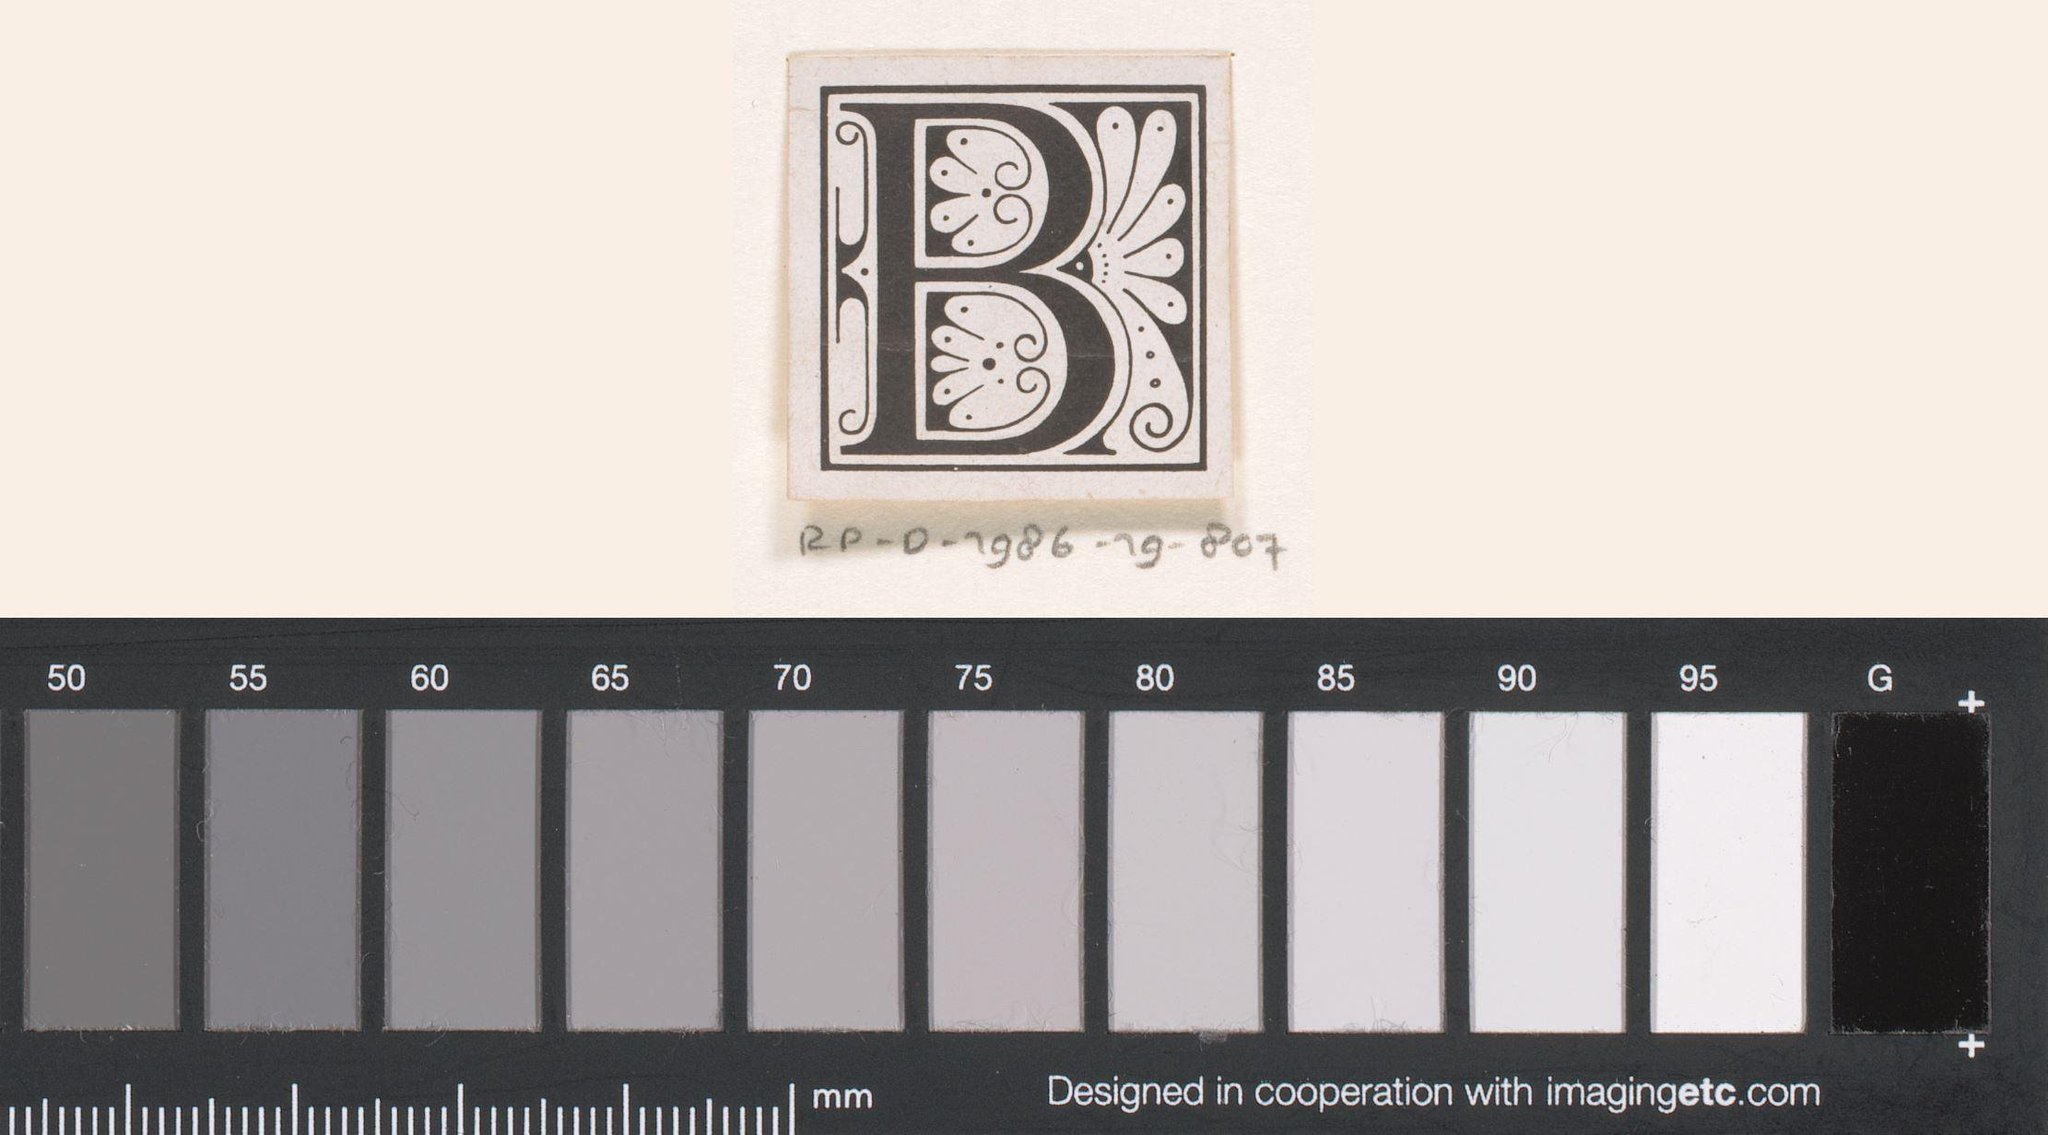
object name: photomechanical print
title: Initiaal B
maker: reinier willem petrus de vries (1874-1953)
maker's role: draughtsman, print maker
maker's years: 1874-1953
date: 1904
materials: paper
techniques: printing block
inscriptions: collector's mark: ‘R:MVS.’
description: Het initiaal is gebruikt voor: Veth, Jan. Jozef Israëls en zijn kunst. Arnhem en Nijmegen: Gebroeders E&M Cohen, 1904.